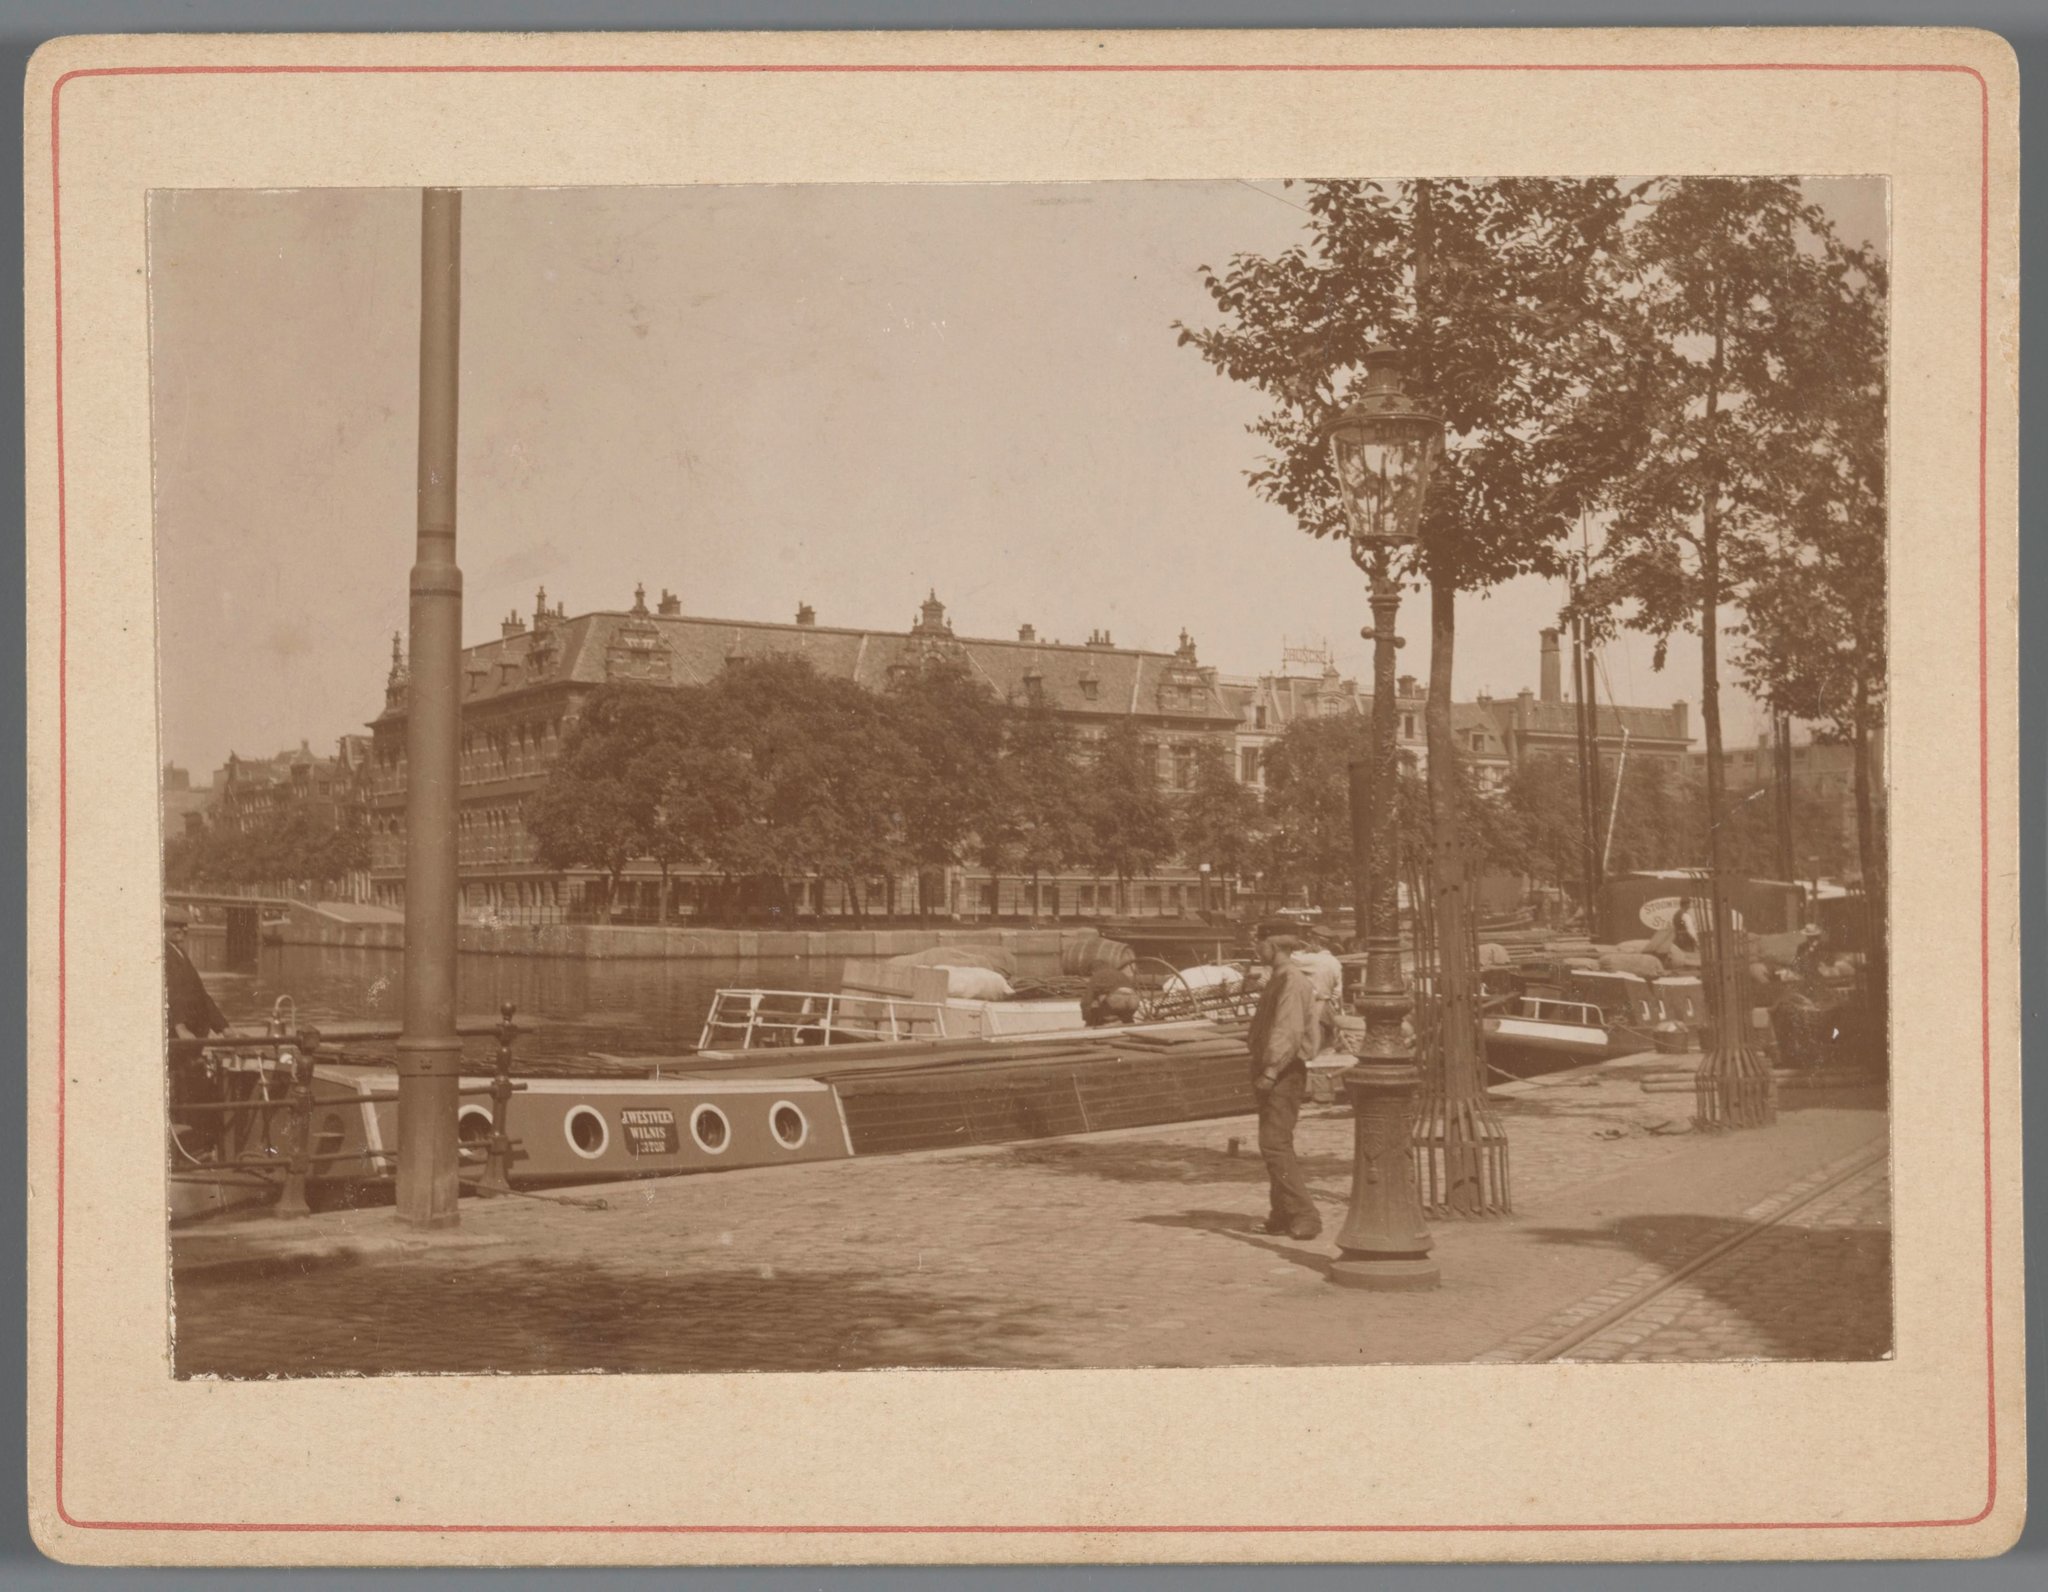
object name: photograph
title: Amsterdam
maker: Anonymous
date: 1900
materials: cardboard, photographic support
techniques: gelatin silver print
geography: amsterdam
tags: amstel (rivier), zwanenburgwal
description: Gezicht op de hoek van de Amstel de Zwanenburgwal te Amsterdam. Op de hoek, Amstel 1, het Diaconie-weeshuis van de Nederlands Hervormde Gemeente. Op nummer 5 het pand van de firma Weduwe J.T. Hunck, leveranciers van kolen- en gasfornuizen. Onderdeel van een groep van 5 foto's en 19 stereofoto's gemaakt door een onbekende amateurfotograaf rond 1900 in Amsterdam, de Ardennen en Denemarken.